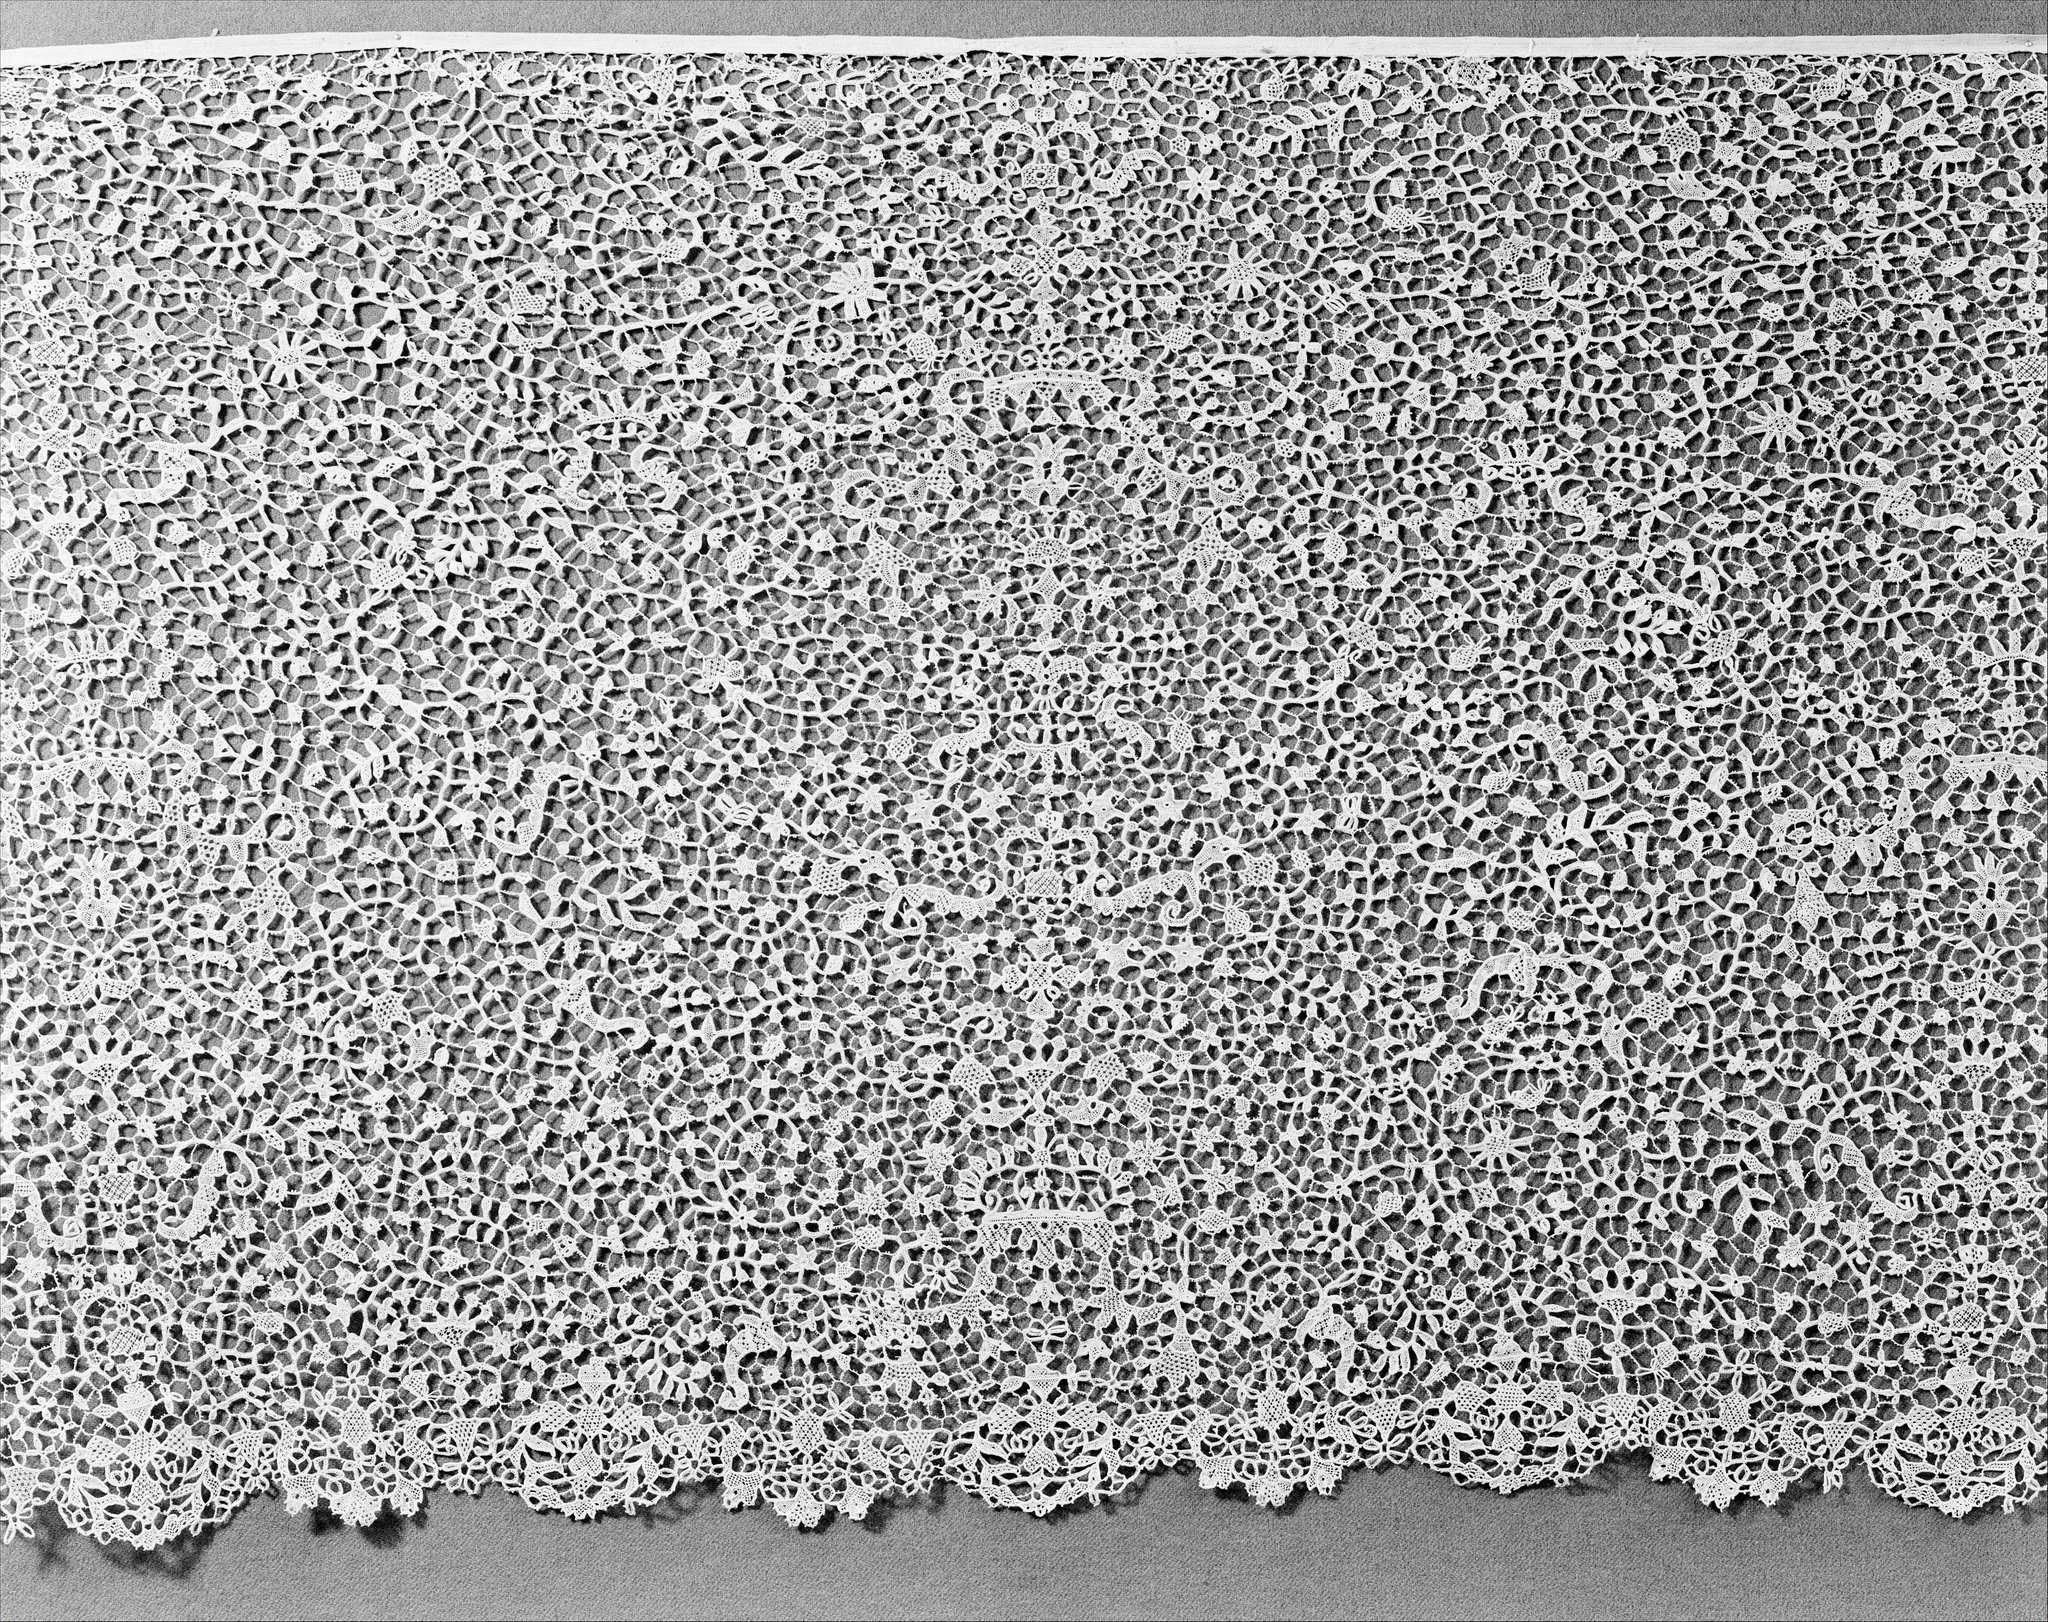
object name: flounce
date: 1701-1733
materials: linen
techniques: lace